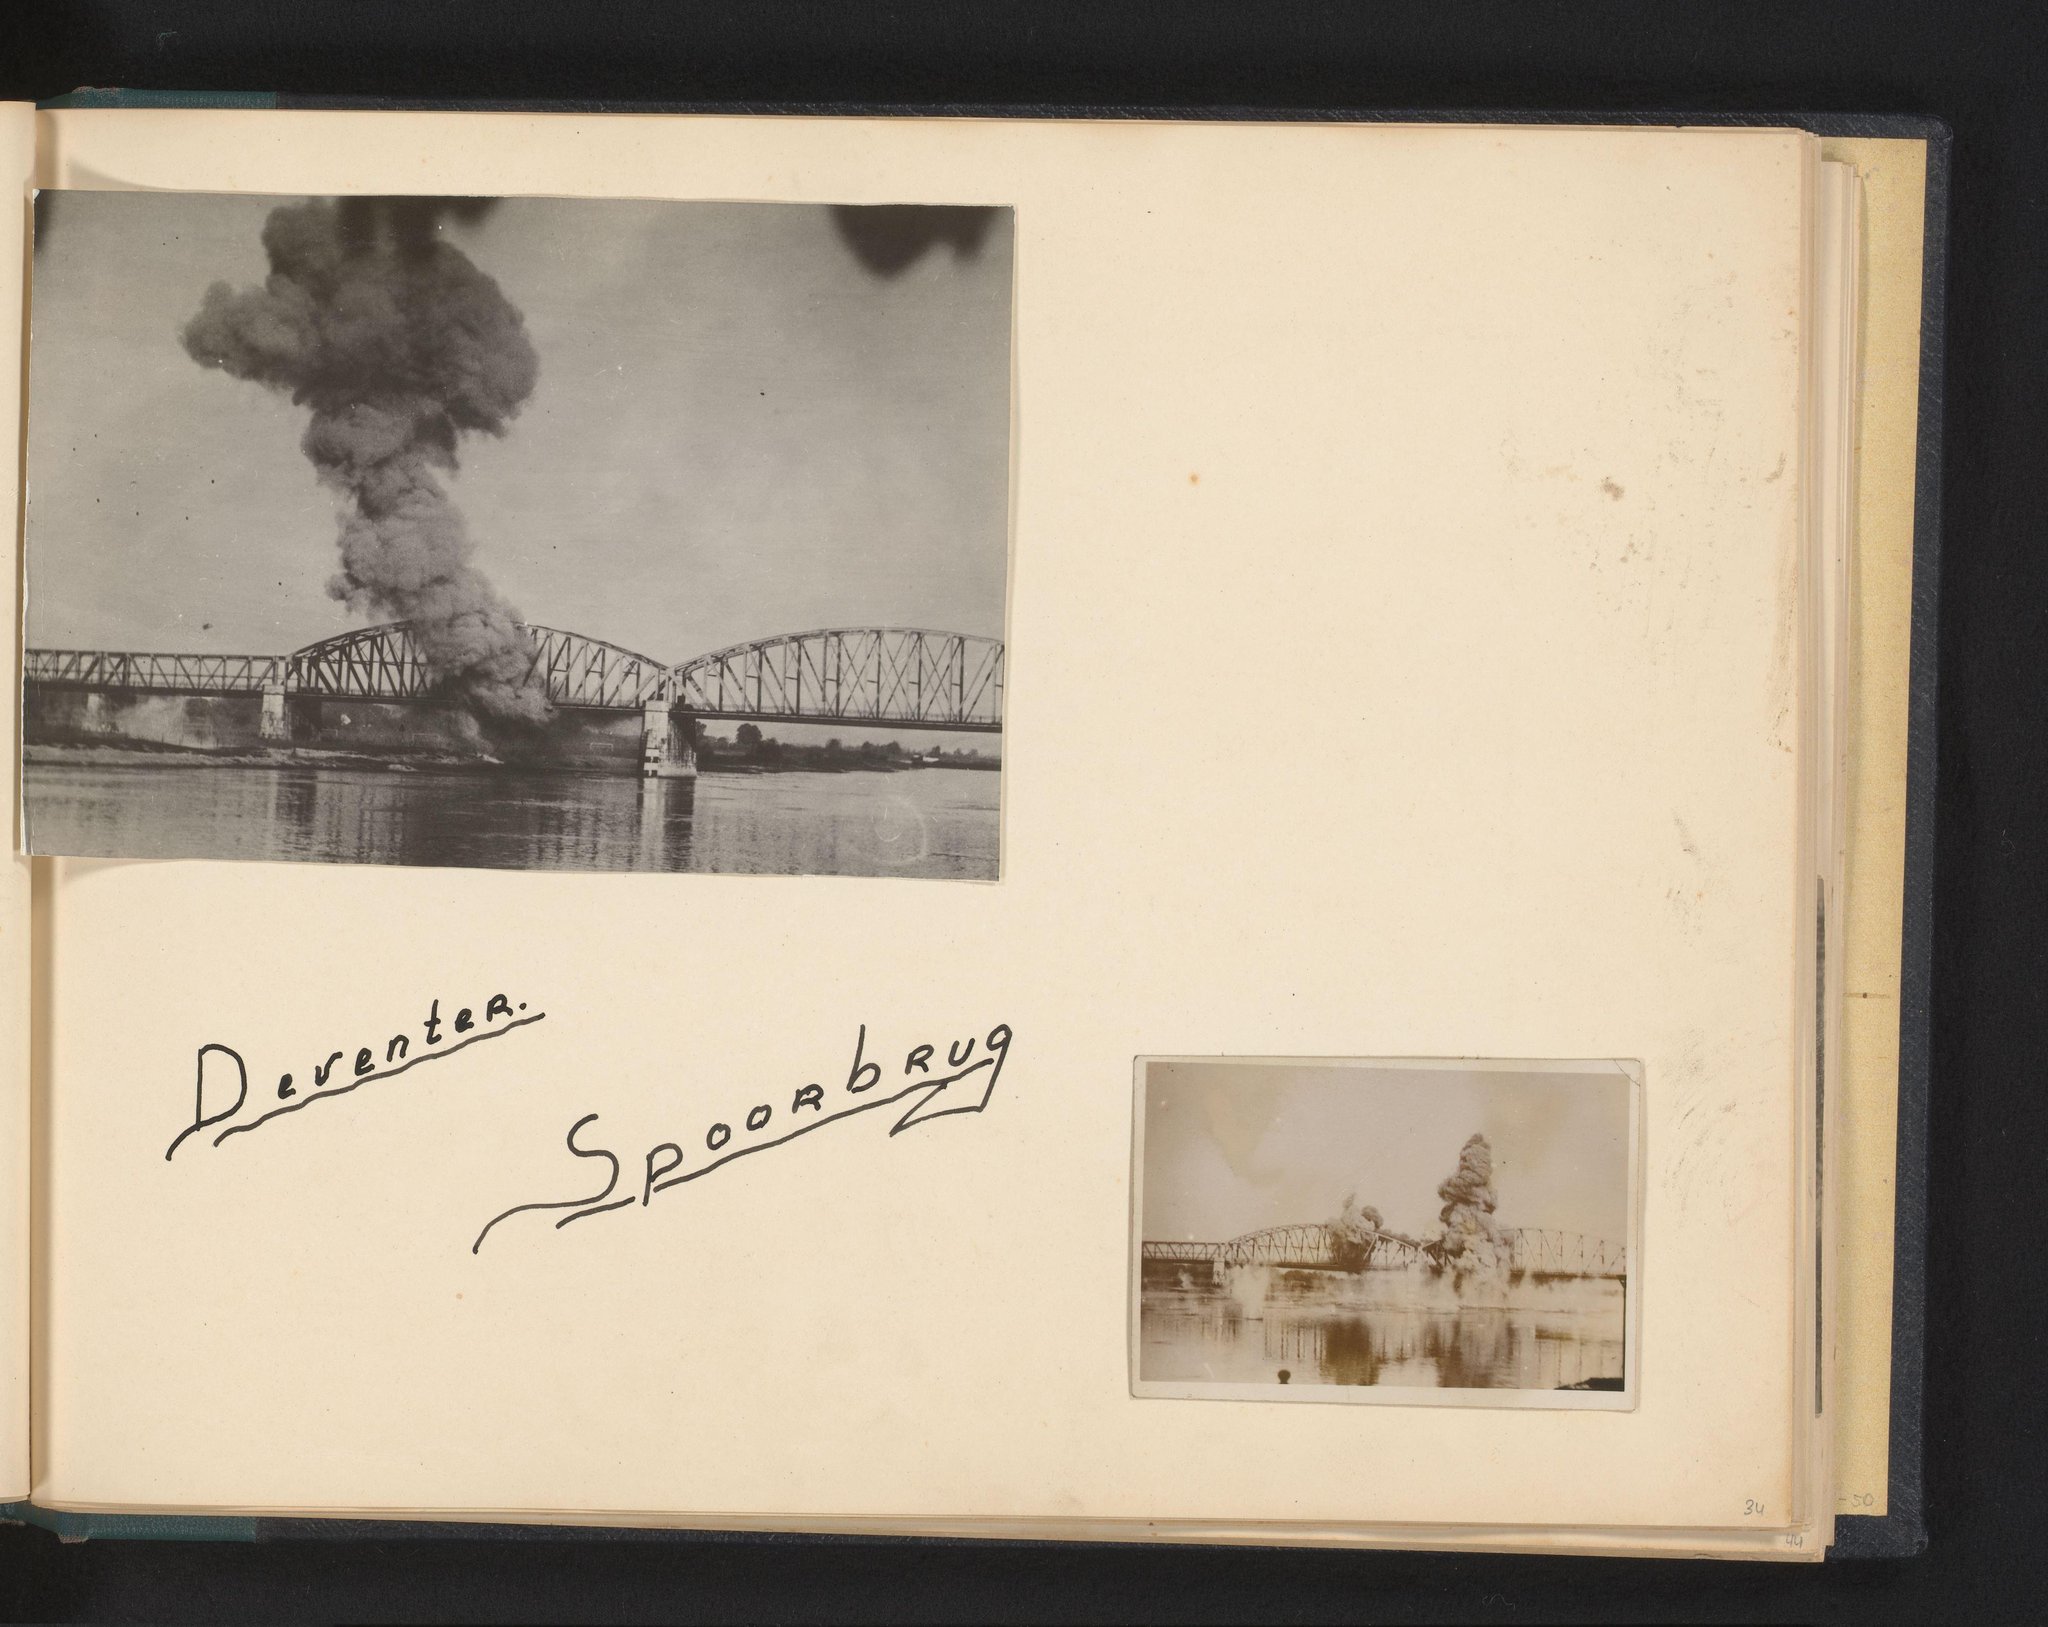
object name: photograph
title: Deventer. Spoorbrug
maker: arnoldus vrauwdêunt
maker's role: graficus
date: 1940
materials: cardboard, paper, photographic support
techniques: gelatin silver print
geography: deventer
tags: obstructions, barricades (defensive measures), railway, tramway; rack railway, bridge, projectiles, explosives, etc., netherlands, deventer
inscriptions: inscription: ‘Deventer. Spoorbrug’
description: Albumblad met twee foto's van het opblazen van de spoorbrug bij Deventer op 10 mei 1940, in een poging om de opmars van het Duitse leger te bemoeilijken. Onderdeel van het fotoalbum over de verwoestingen van Nederlandse steden en infrastructuur in het begin van de Tweede Wereldoorlog.